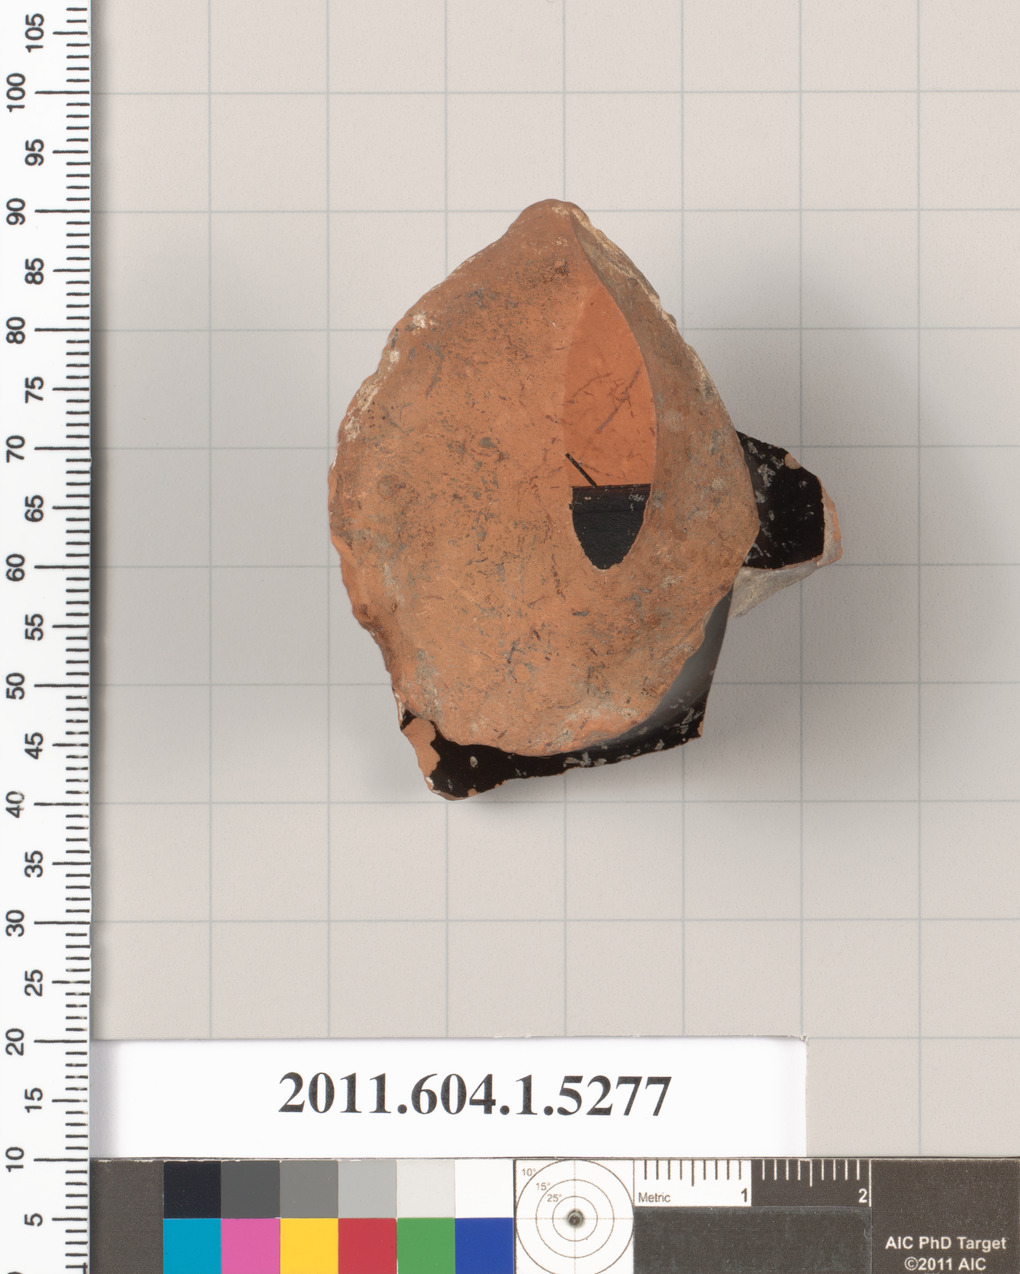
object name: kylix fragment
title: Terracotta fragment of a kylix (drinking cup)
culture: greek, attic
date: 475-451 BCE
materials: terracotta